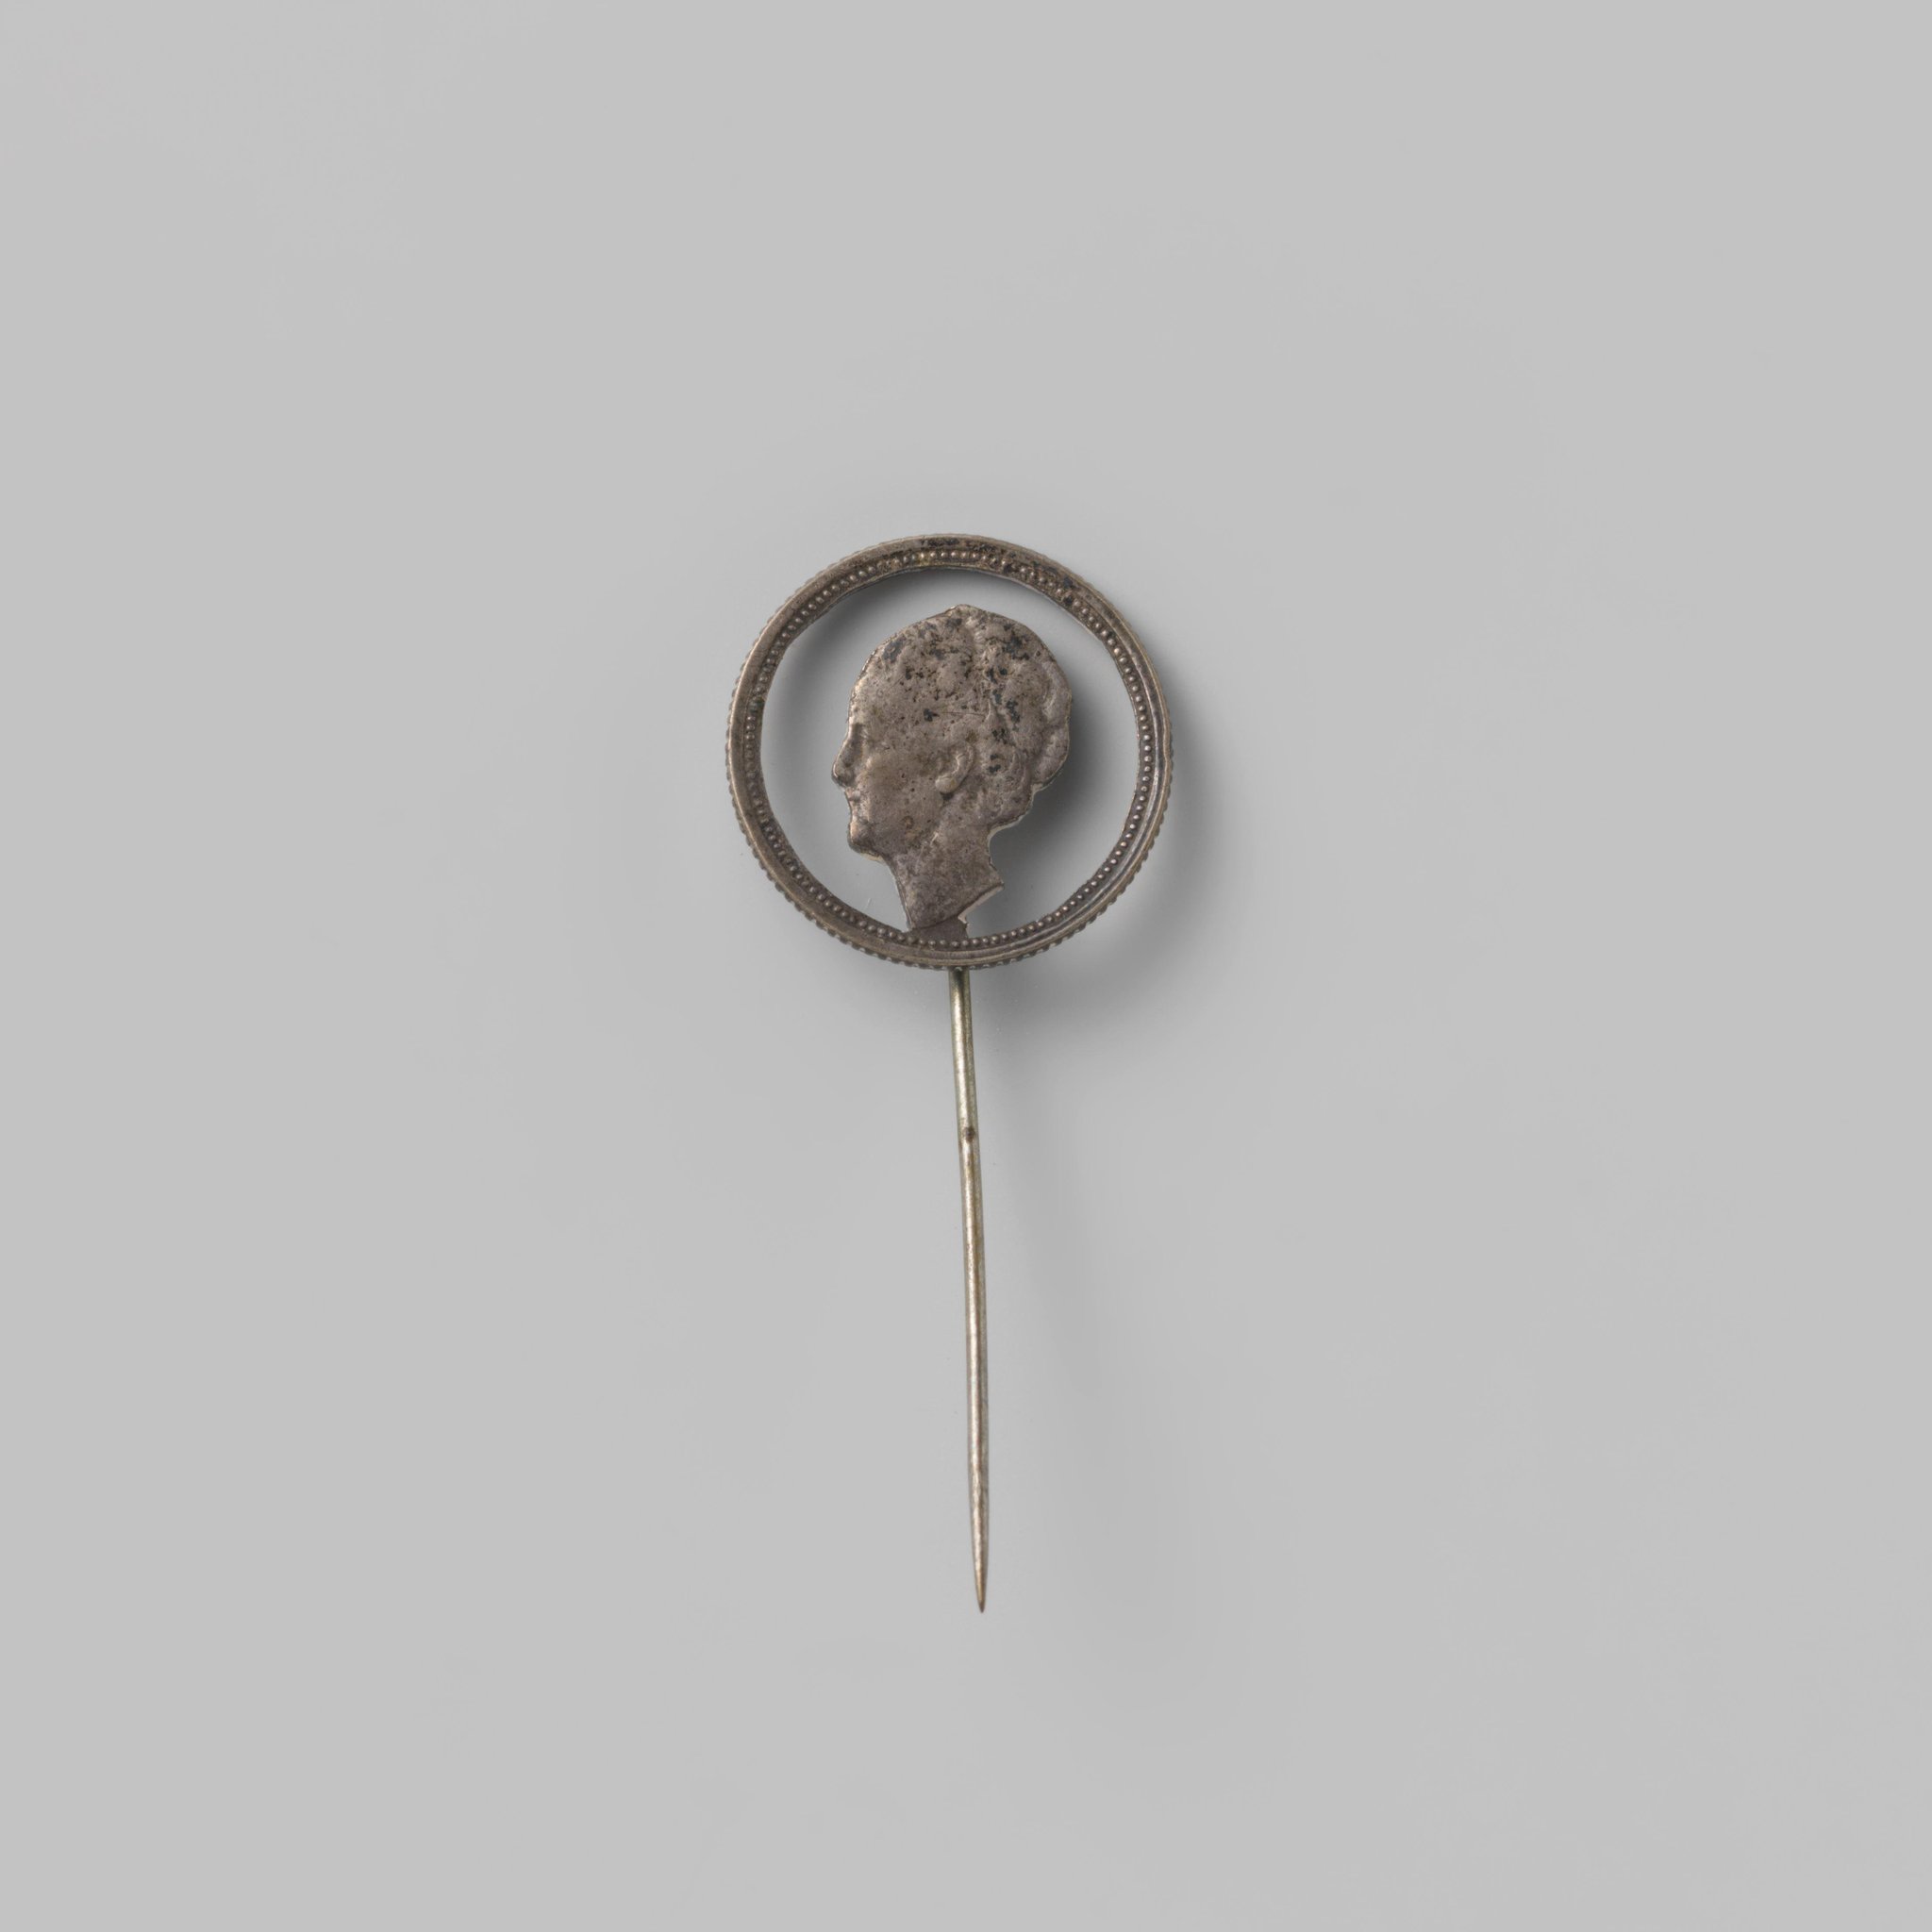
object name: lapel pin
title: Miscellaneous coin jewellery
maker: Anonymous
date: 1940-1950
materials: silver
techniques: sawing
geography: netherlands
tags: print maker, wilhelmina of the netherlands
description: Silent Resistance –War and Liberation Jewellery During the Second World War, small pieces of jewellery were worn in the Netherlands as a silent protest against the German occupier. In April 1941, Dutch coins were officially confiscated for the war industry. As jewellery did not have to be surrendered, coins were quickly transformed into rings, brooches, pins and bracelets. A portrait of Queen Wilhelmina was worn as a sign of resistance, as well as a token of loyalty to the royal family. Margriet Francisca, the third daughter of Princess Juliana and Prince Bernard, was born in Canada in January 1943. The pin with the three yellow chicks refers to the three young princesses Beatrix, Irene and Margriet and the steadfastness of the Dutch royal family. After the liberation, coins and silver were used for jewellery conveying messages of hope for a peaceful future.